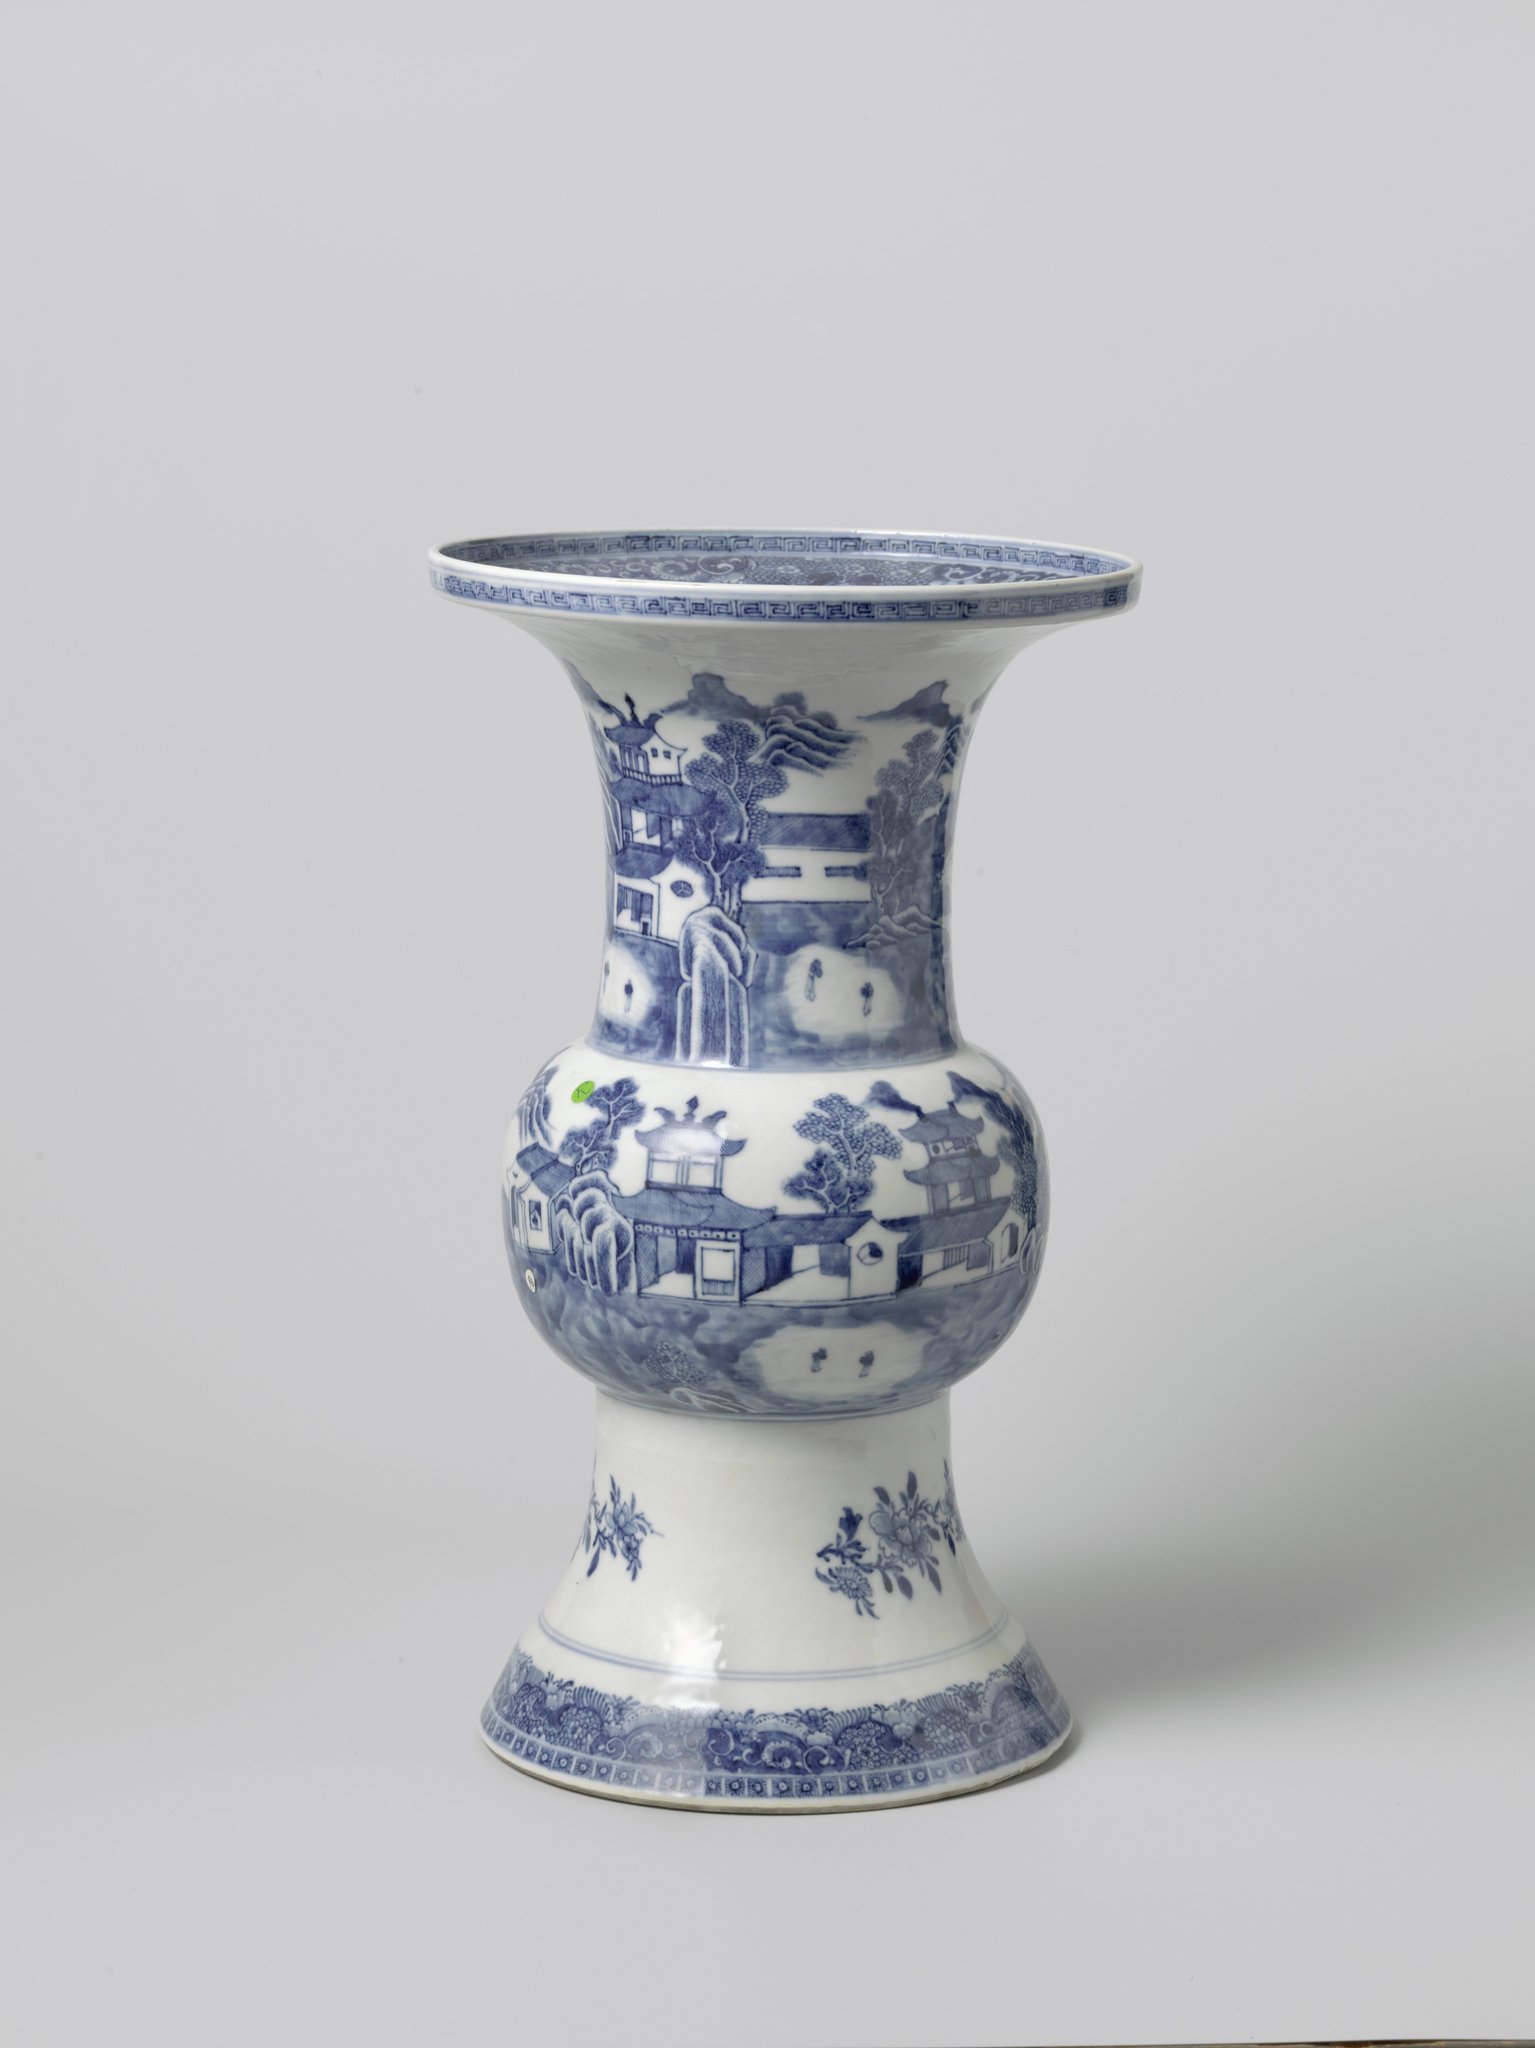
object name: vase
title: Vase with riverlandscapes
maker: Anonymous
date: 1775-1799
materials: cobalt, glaze, paint, porcelain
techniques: firing, turning, vitrification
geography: china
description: Vaas met een bolle buik op een hoge spreidende voet en met een wijd spreidende hals met opstaande rand. Beschilderd in onderglazuur blauw met landschappen op het lichaam en de hals; bloemtakken op de voet en decoratieve banden langs de rand en de voetrand.